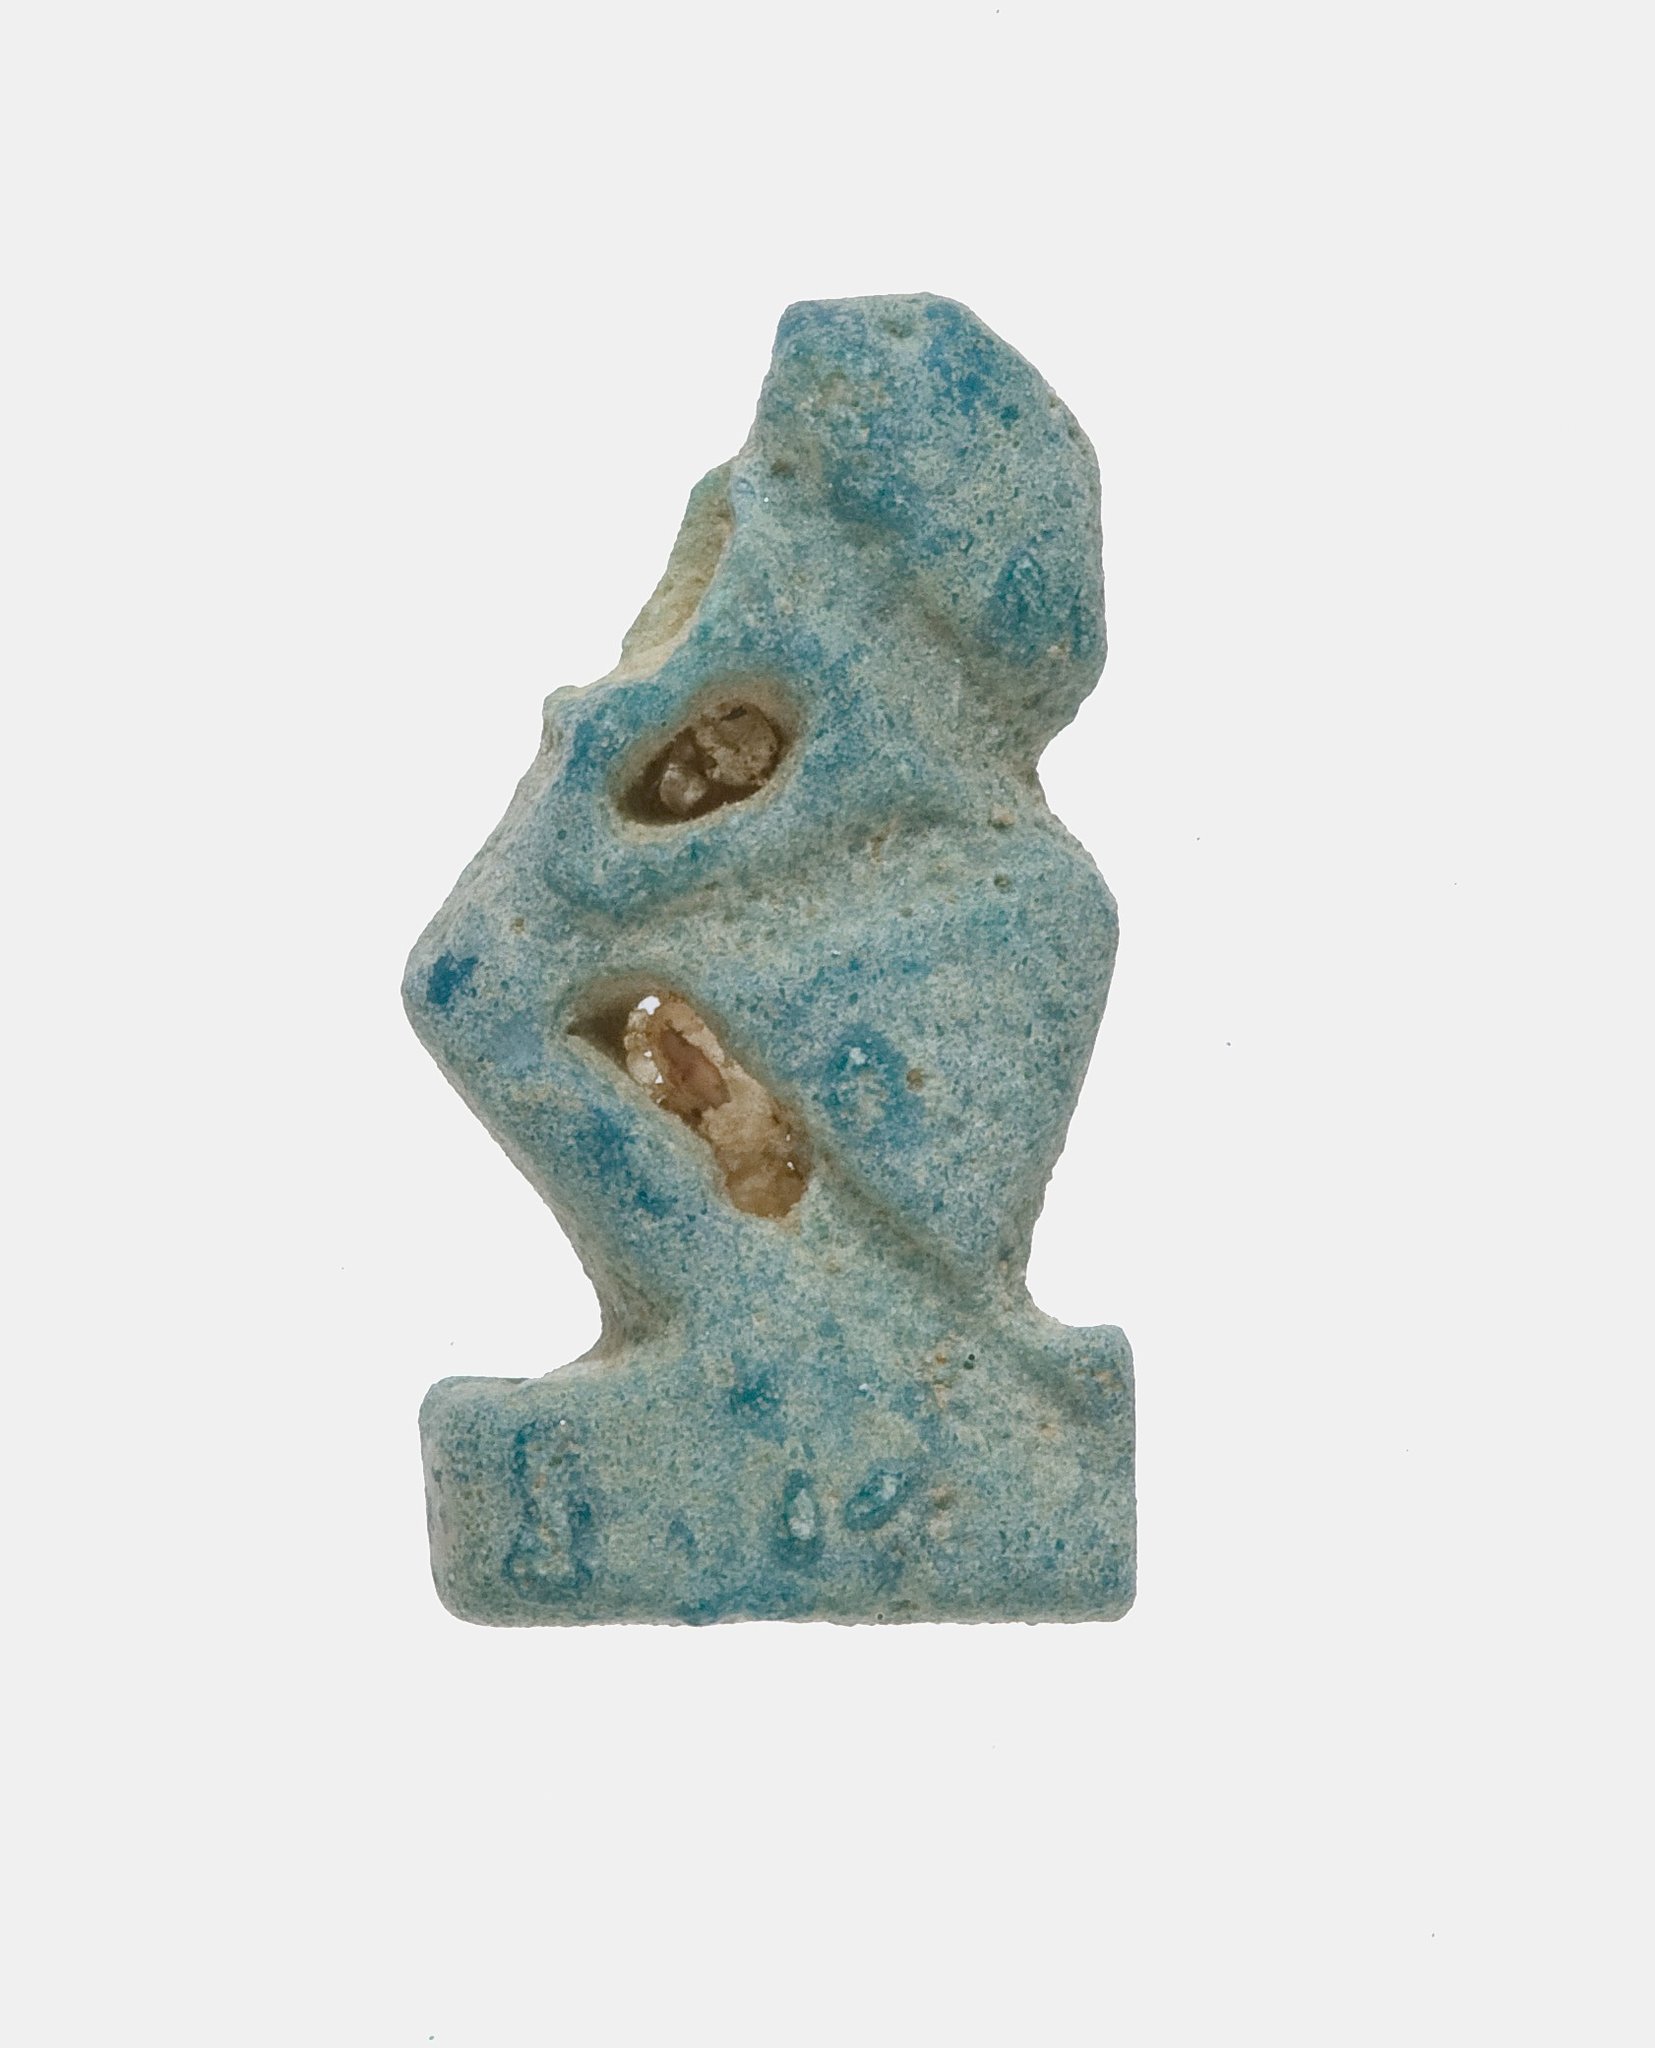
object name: amulet, baboon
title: Baboon (?) Amulet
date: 1802-1450 BCE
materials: faience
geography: egypt